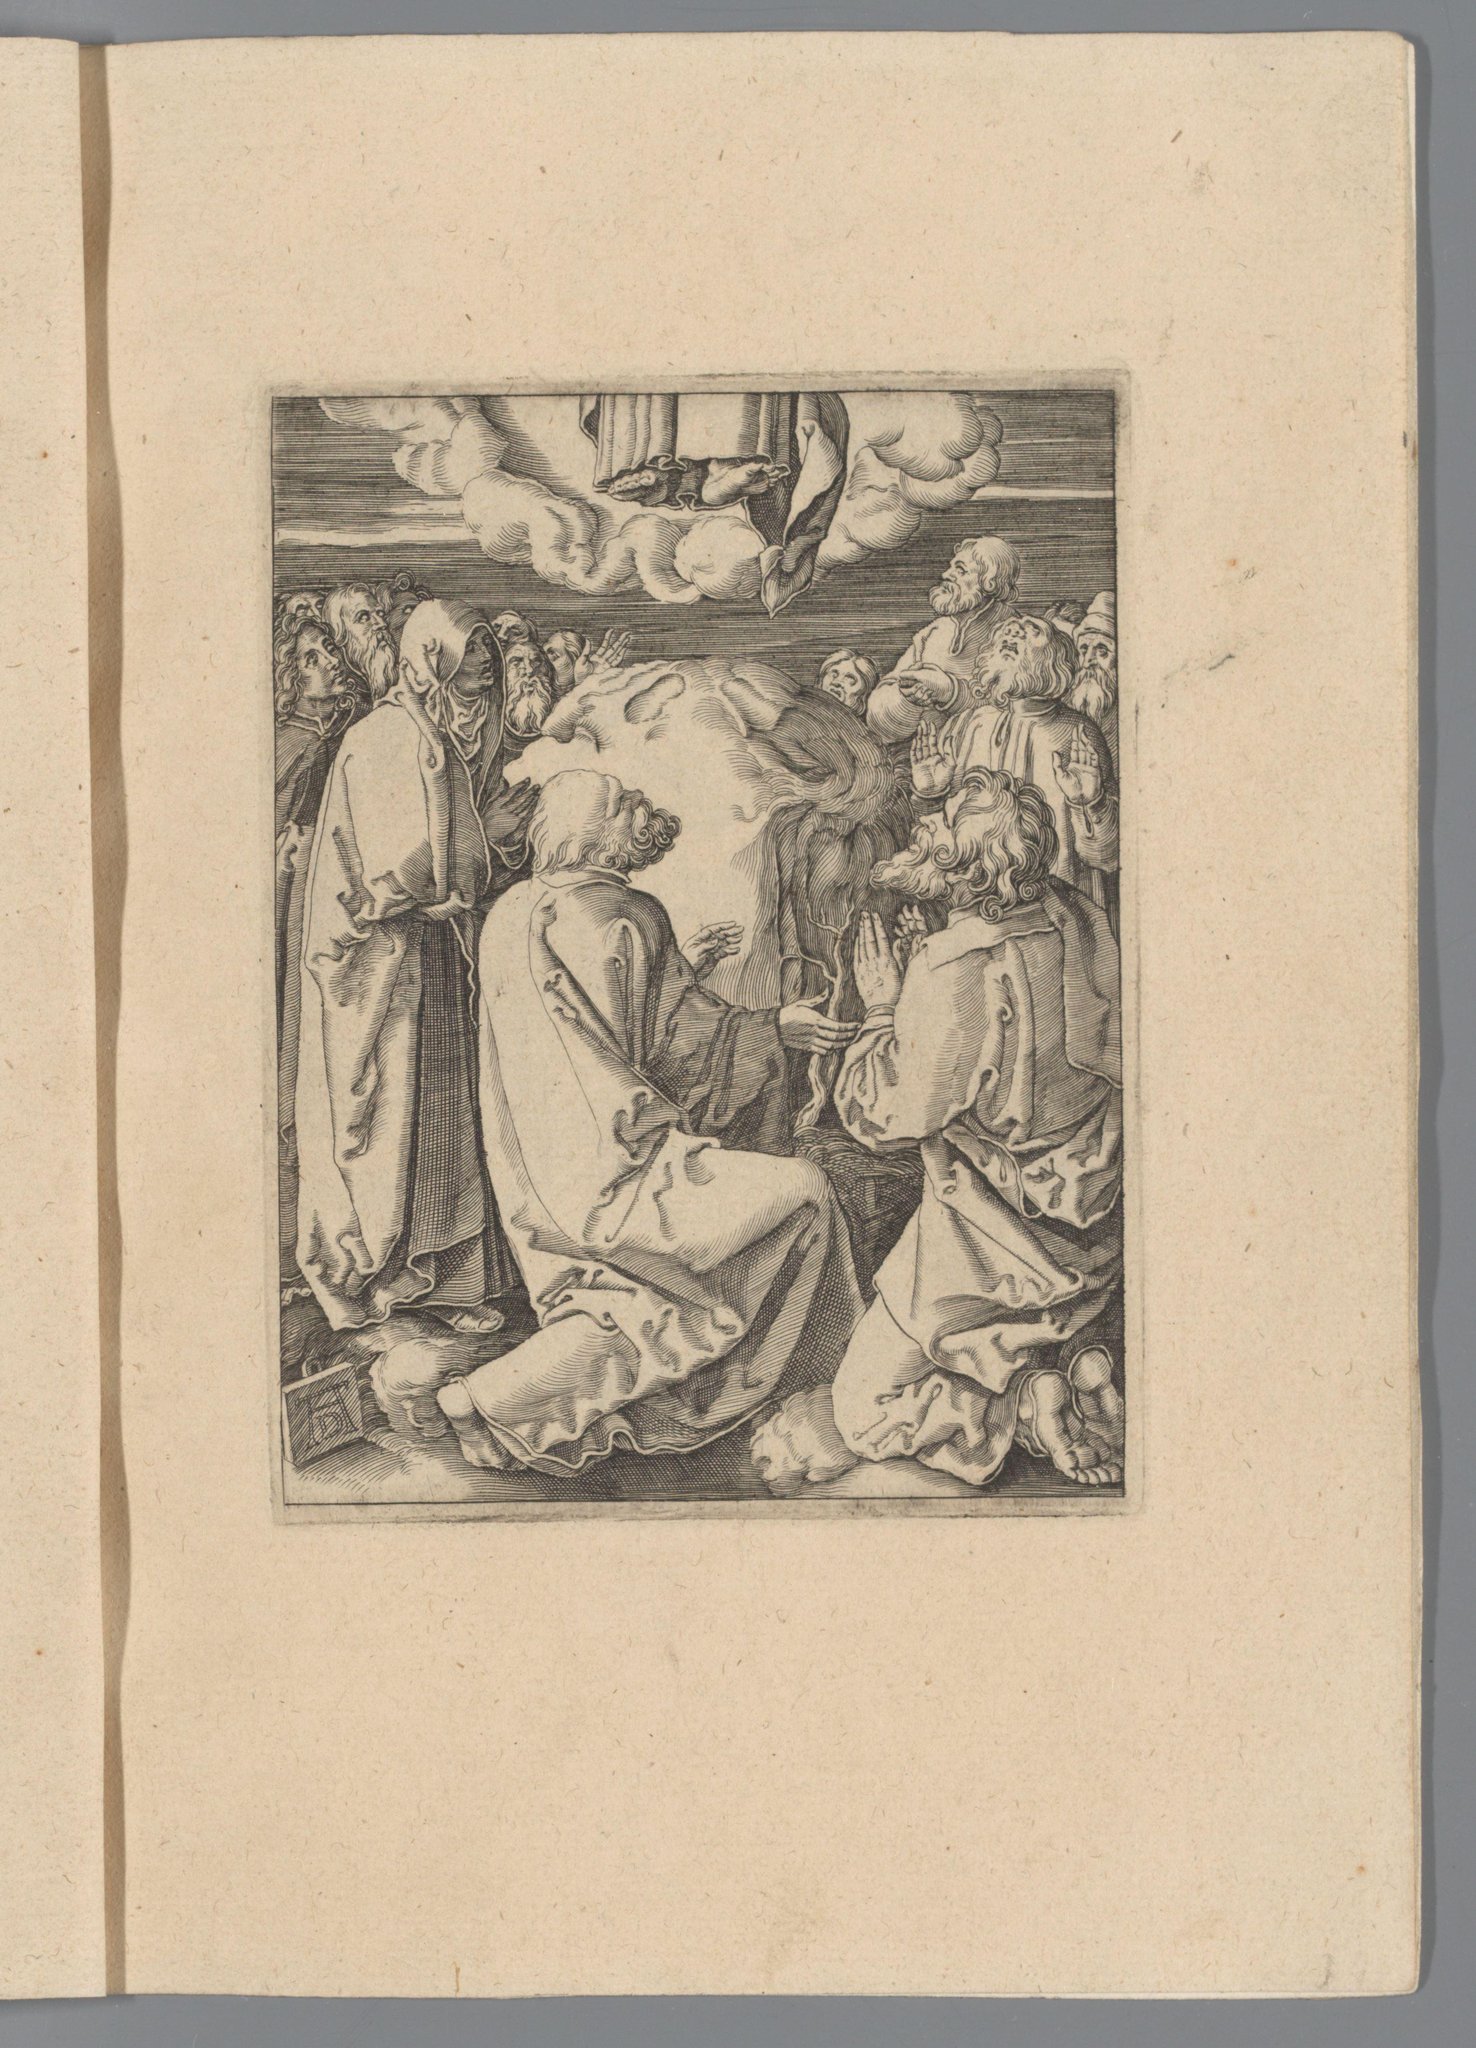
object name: print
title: Passio Christi Ab Alberto Durer Nurenburgensi Effigiata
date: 1610-1620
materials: paper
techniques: engraving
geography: the hague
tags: christ almost vanished: only feet visible ~ ascension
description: Christus stijgt op naar de hemel in het bijzijn van zijn discipelen en zijn moeder. Prent maakt deel uit van een album.